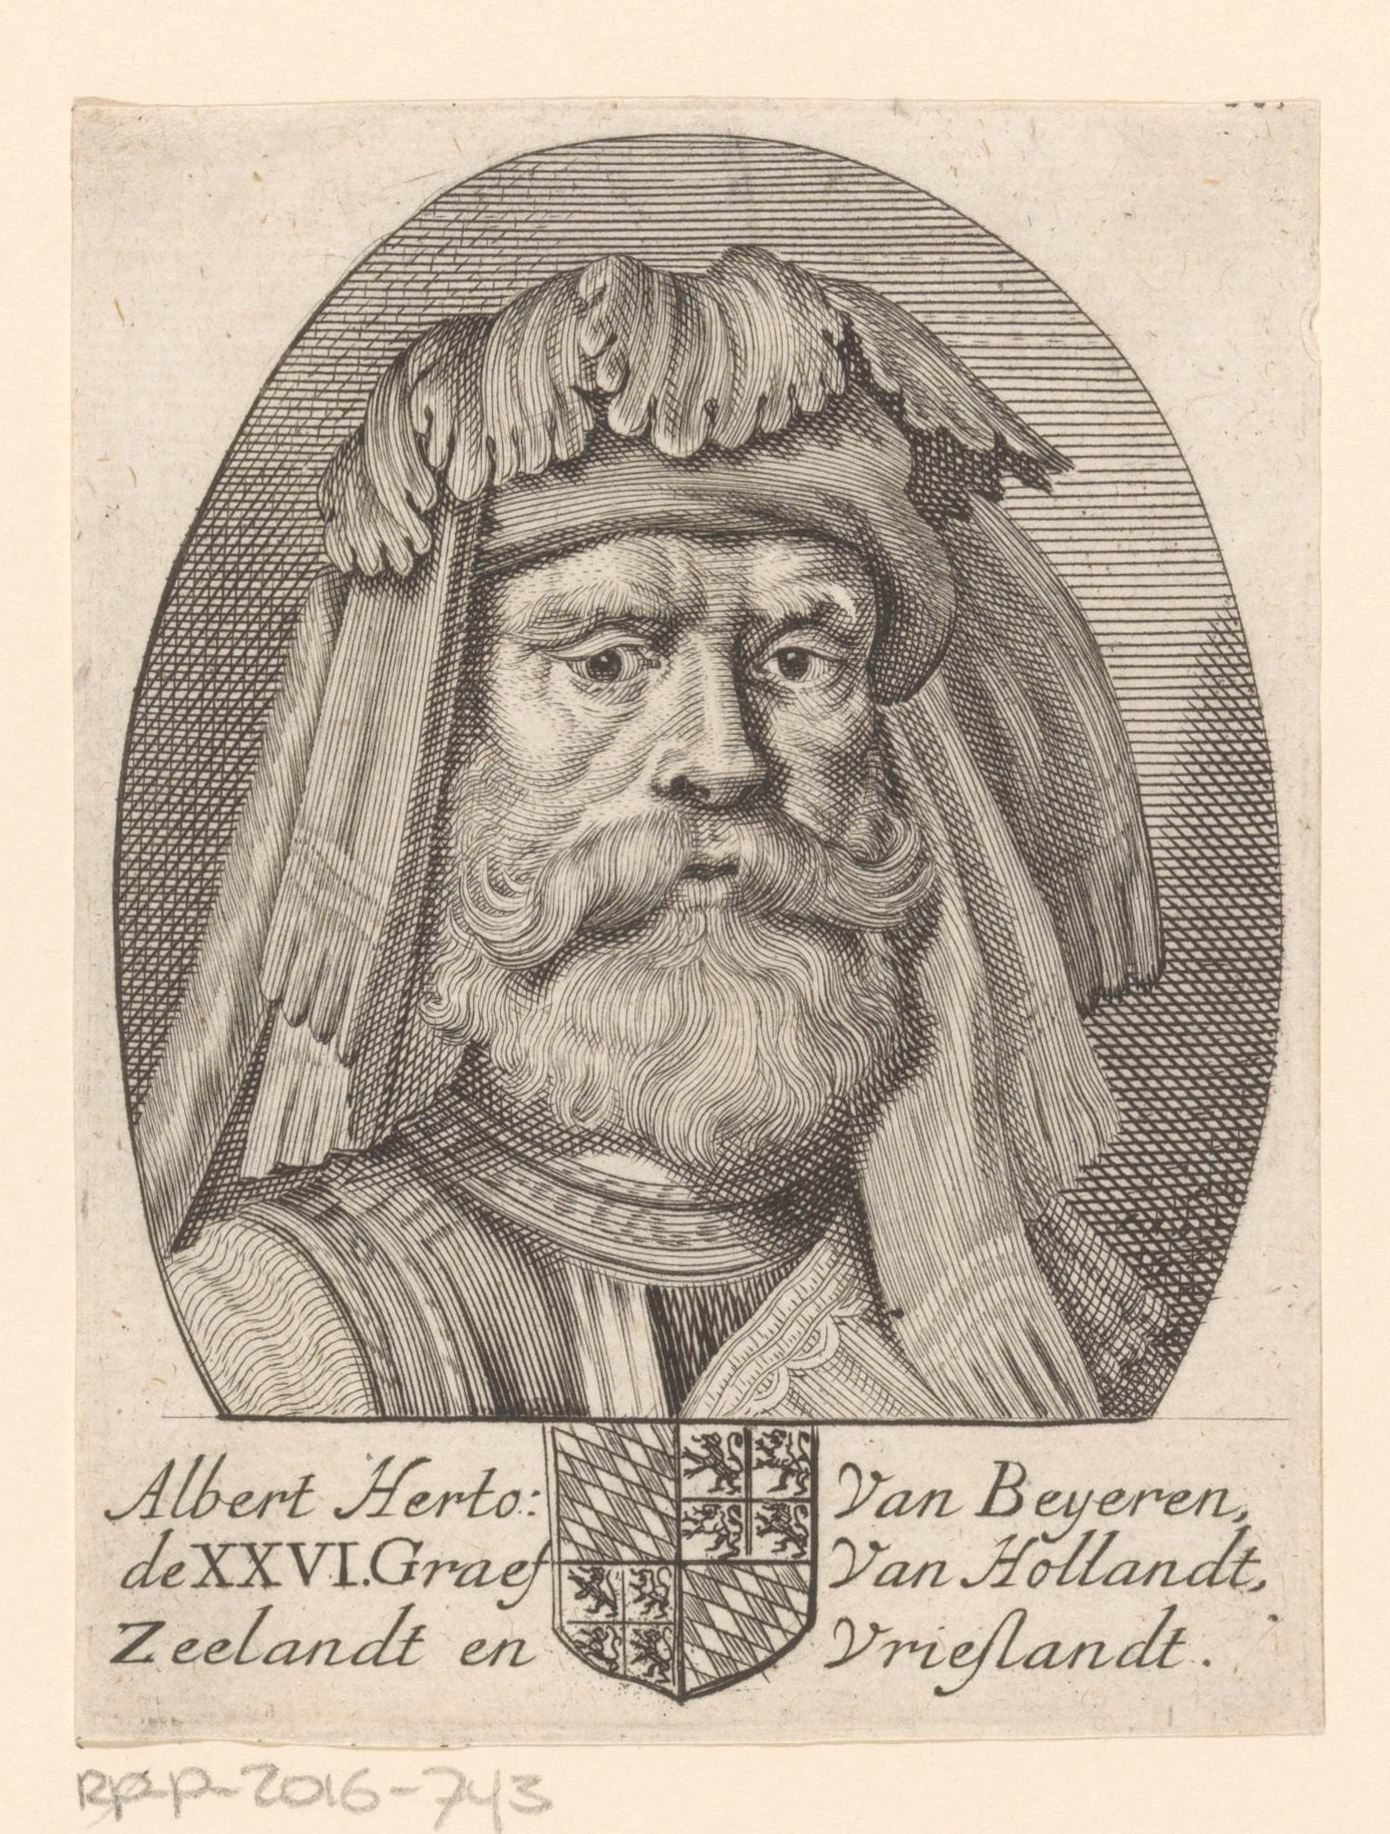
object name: print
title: Portret van Albrecht van Beieren, graaf van Holland, Henegouwen en Zeeland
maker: Anonymous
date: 1600-1699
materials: paper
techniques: engraving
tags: the hague, duke of bavaria albert i